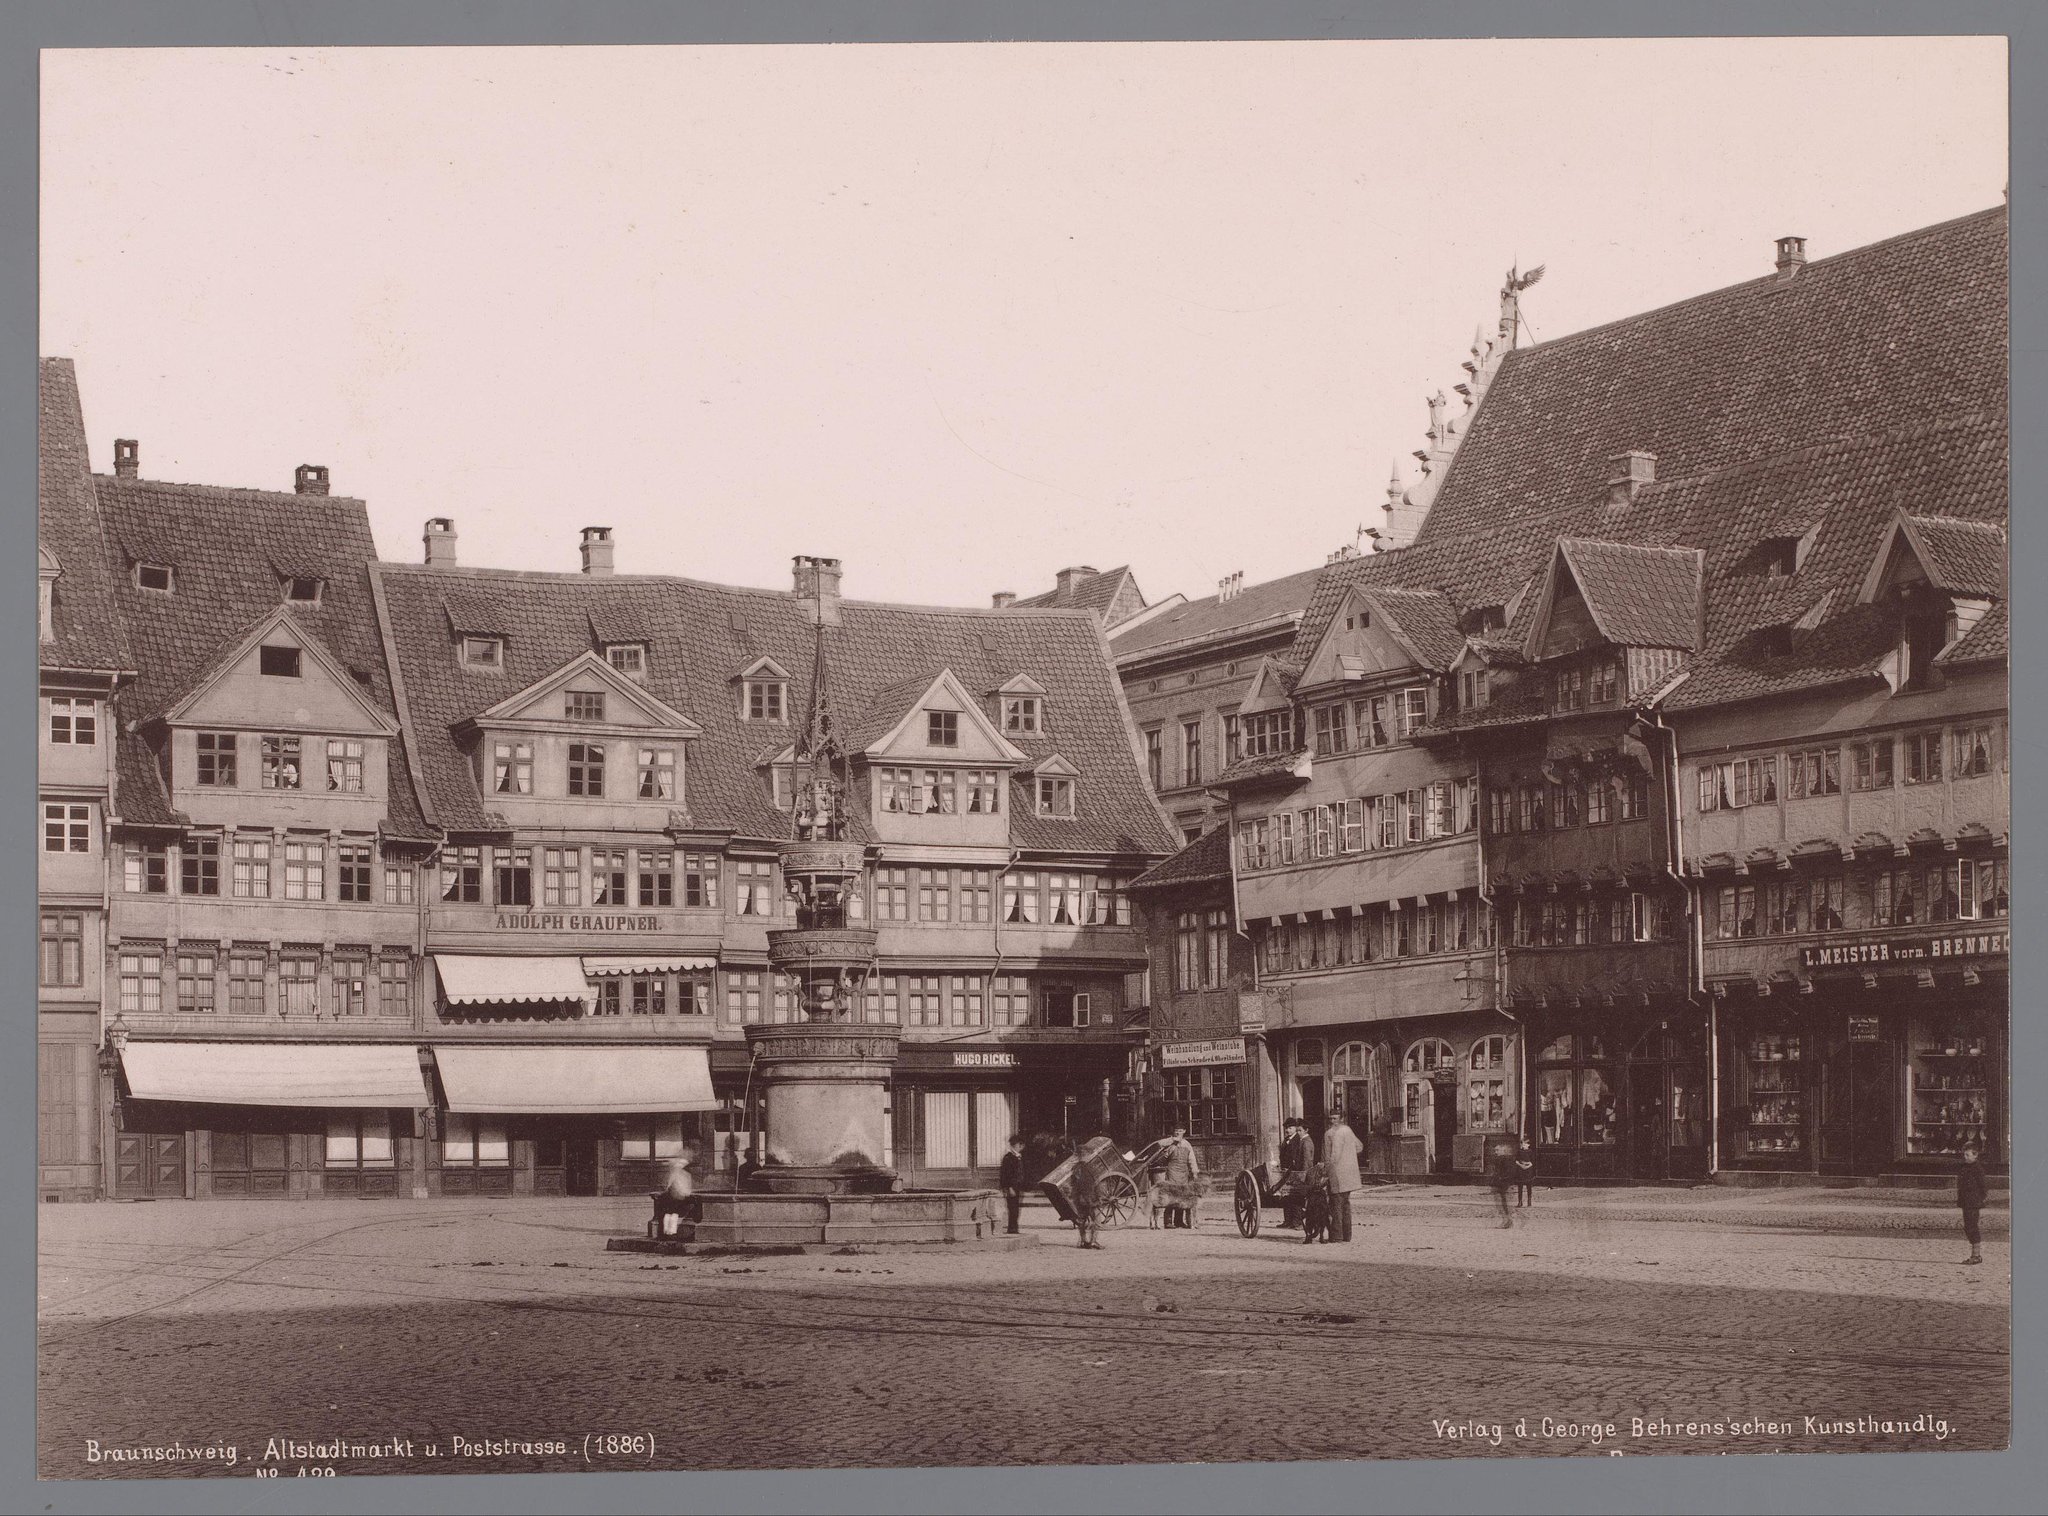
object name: photograph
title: Altstadtmarkt en Poststrasse, Braunschweig, Nedersaksen, Duitsland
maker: george behrens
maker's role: fotograaf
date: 1886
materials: paper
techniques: photograph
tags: braunschweig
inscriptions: number: ‘Verlag d. George Behrens'schen Kunsthandlg.’, inscription: ‘Braunschweig. Altstadt u. Poststrasse. (1886)’, number: ‘429 [?]’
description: Gezicht op een plein in Braunschweig, omringd door huizen/winkels en met een fontein en mensen met (hand-) karren.